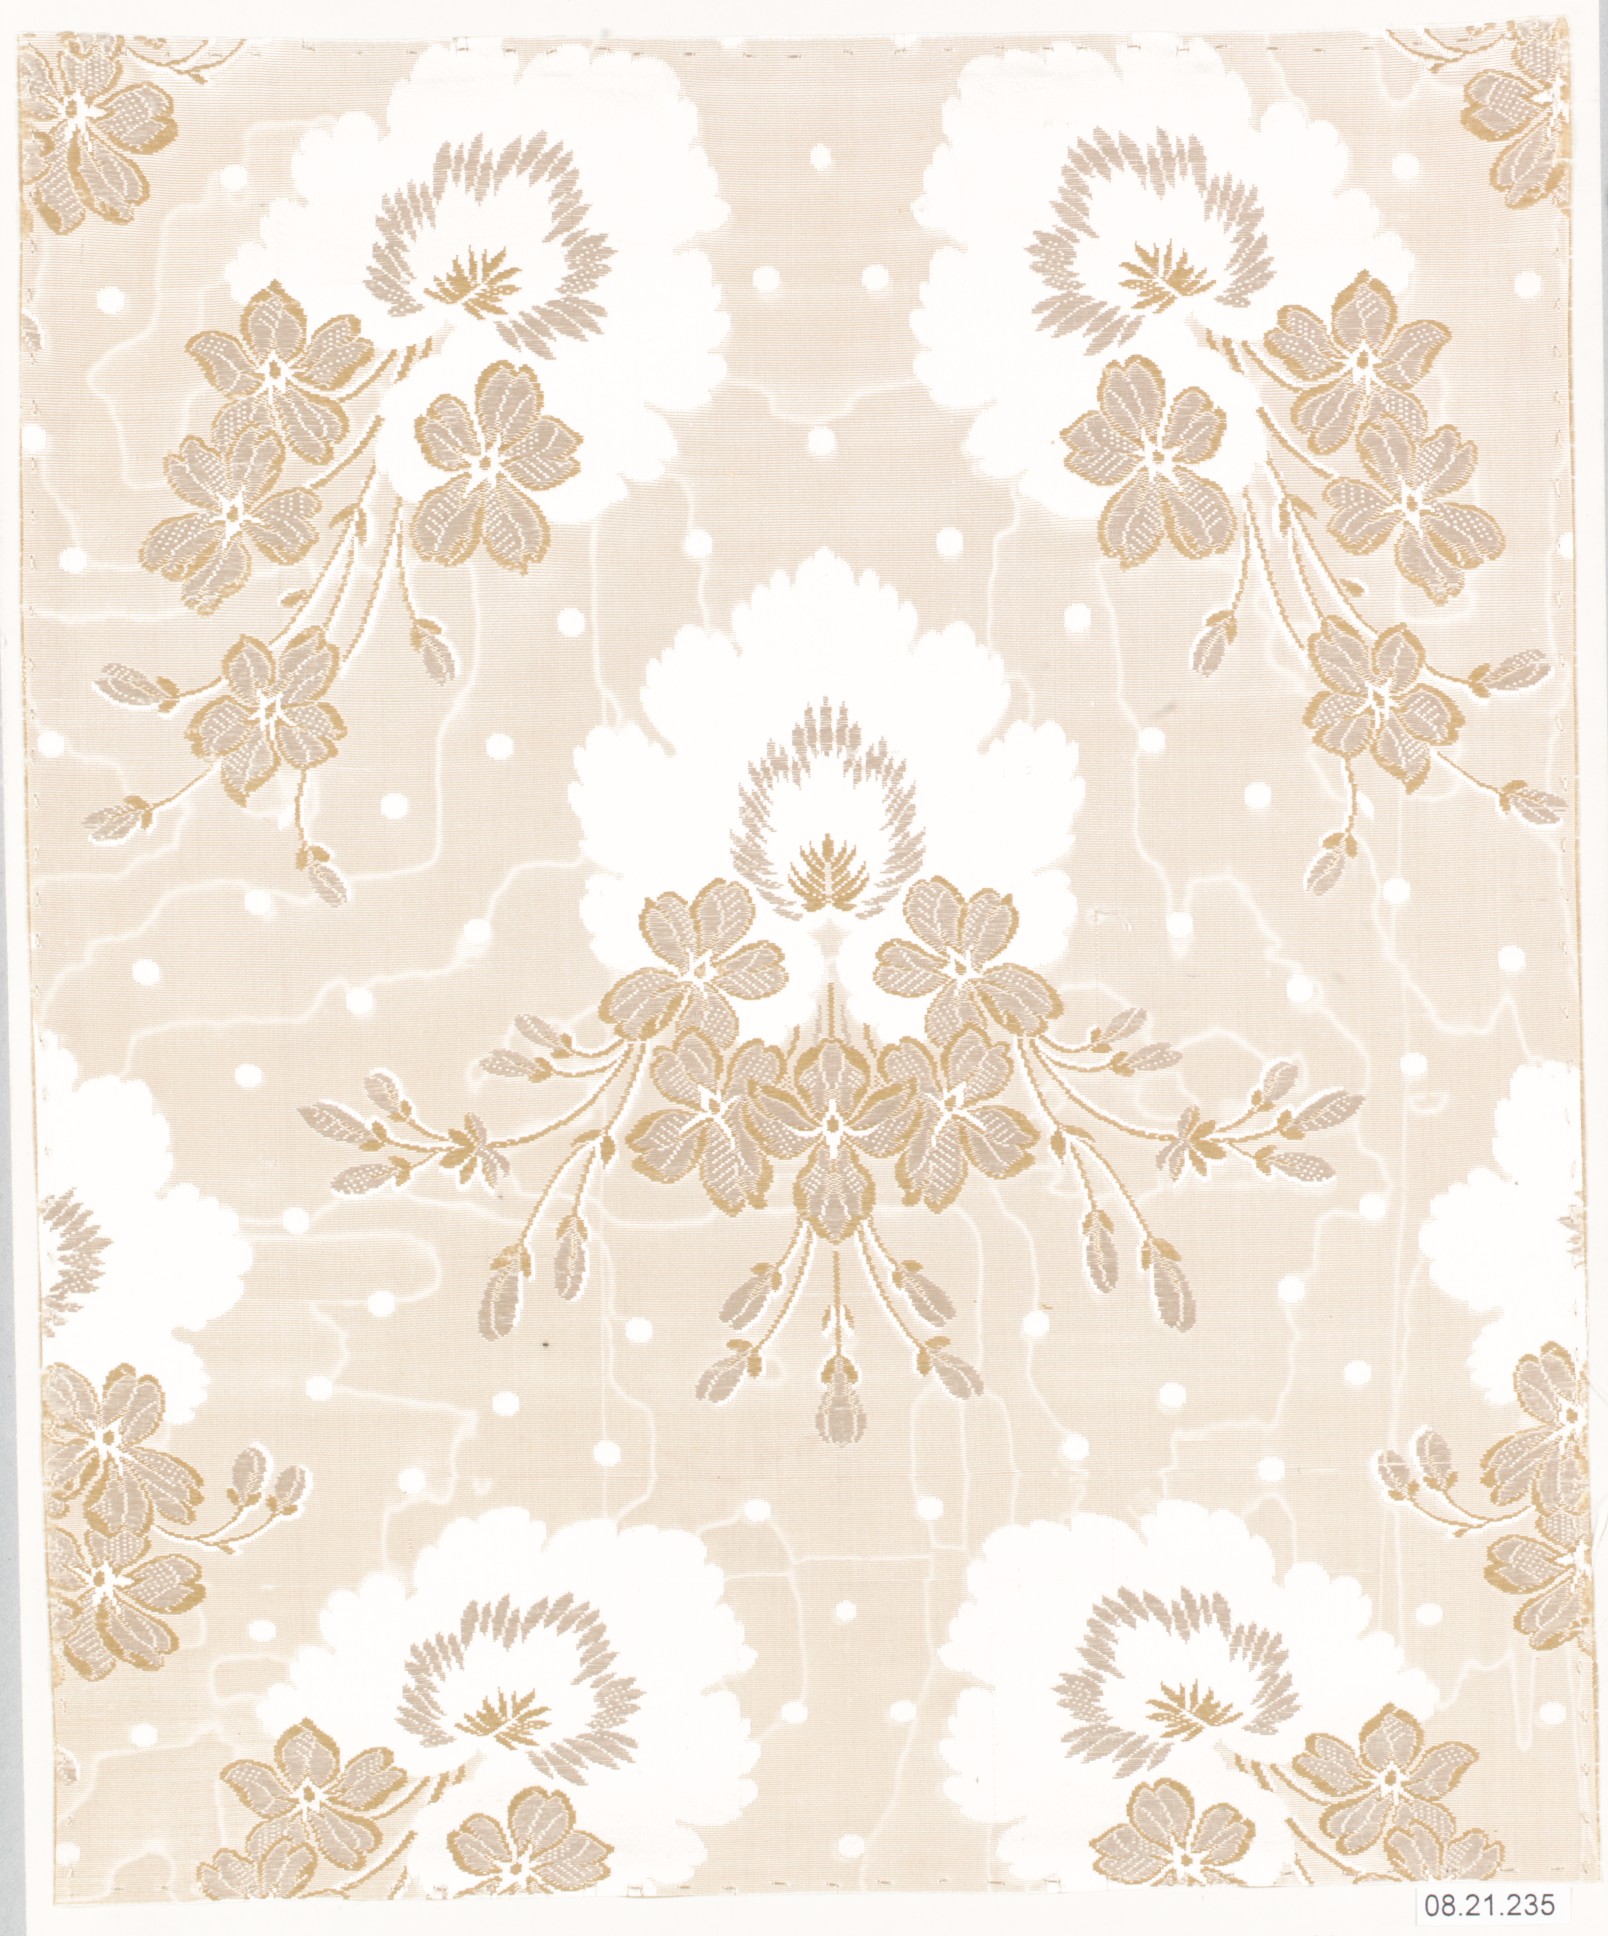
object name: textile sample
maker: Anonymous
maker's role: designer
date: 1900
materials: silk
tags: flowers